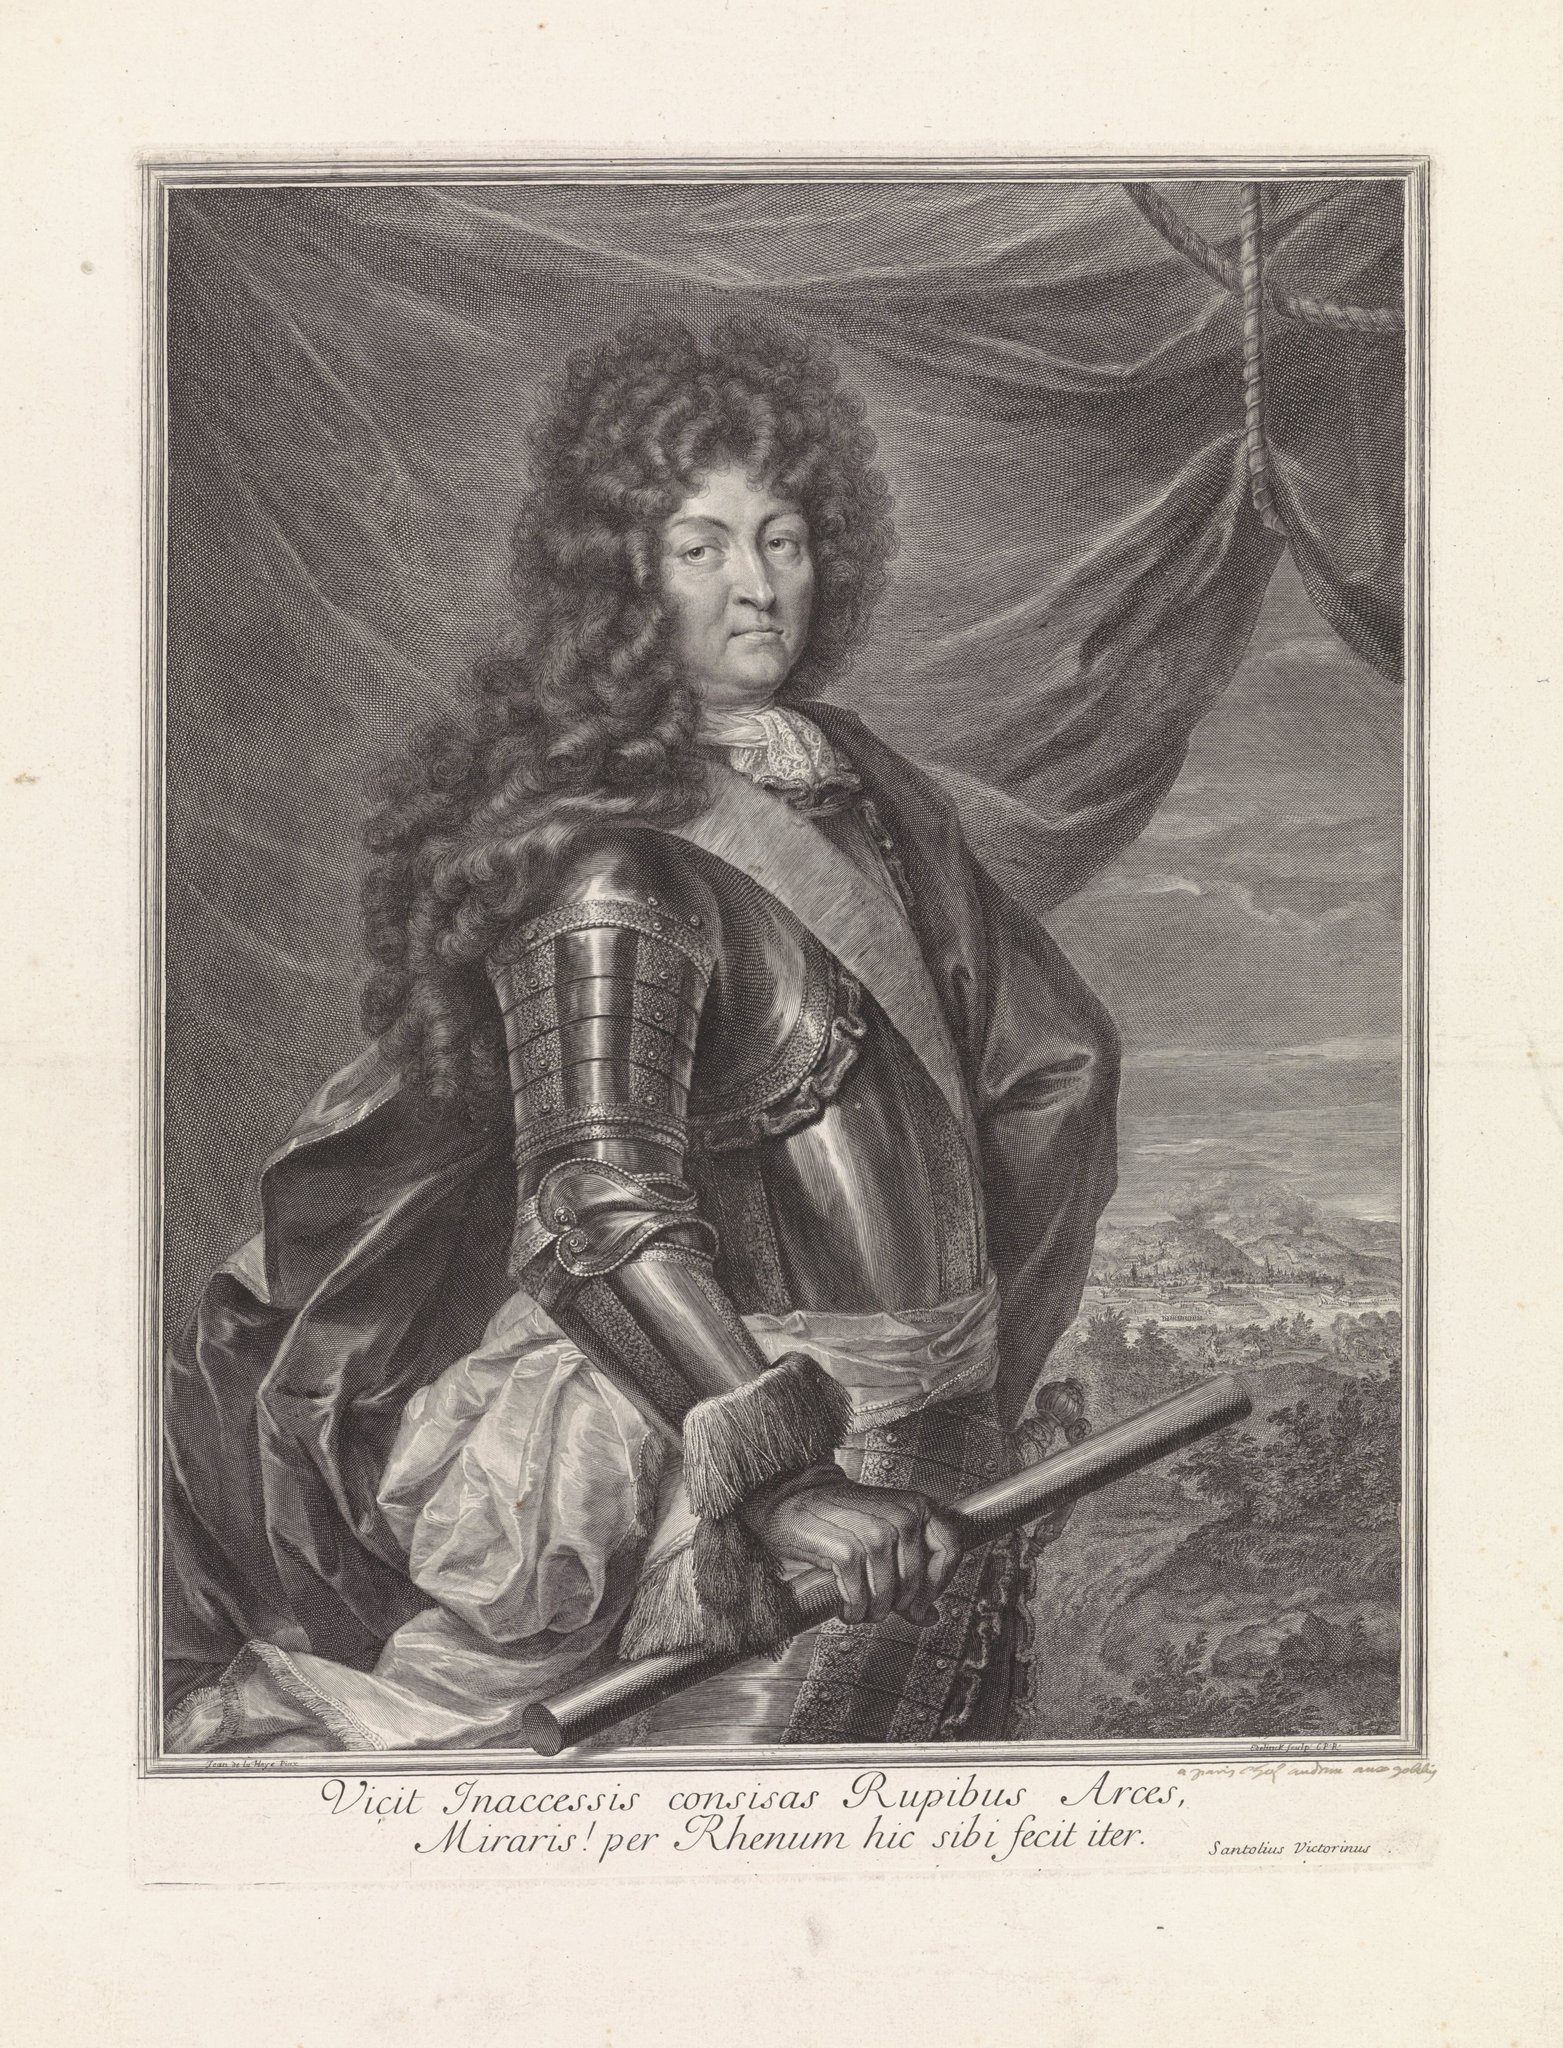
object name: print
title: Portret van Lodewijk de XIV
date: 1666-1707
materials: paper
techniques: engraving, etching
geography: paris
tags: lodewijk xiv (koning van frankrijk)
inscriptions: collector's mark: Lugt 240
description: Portret ten halven lijve van Lodewijk de XIV. De koning is gekleed in harnas met mantel en heeft in zijn rechter hand een commandostaf. Langs het geopende gordijn een gezicht op een landschap met een belegerde stad. Onder de voorstelling een Latijns opschrift van twee regels.